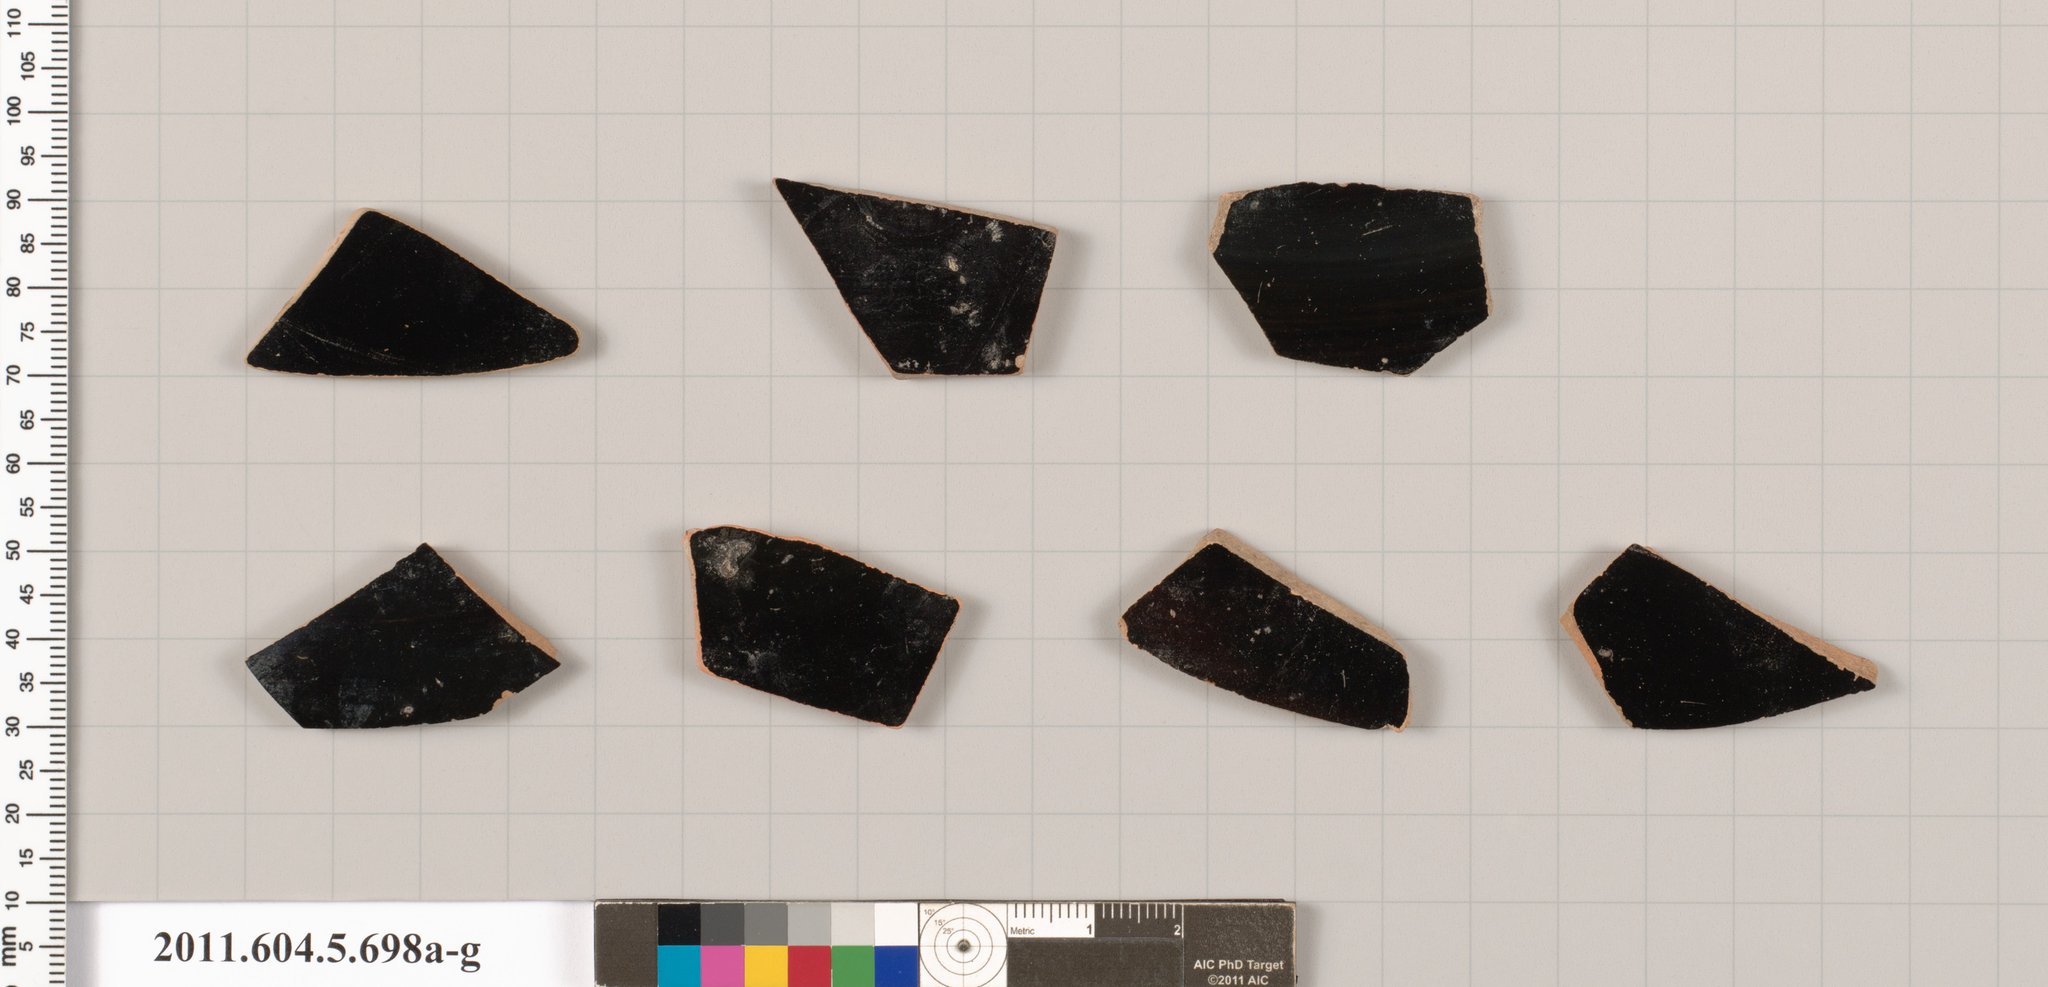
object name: kylix fragment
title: Terracotta fragments of kylikes (drinking cups)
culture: greek, attic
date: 600-401 BCE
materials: terracotta